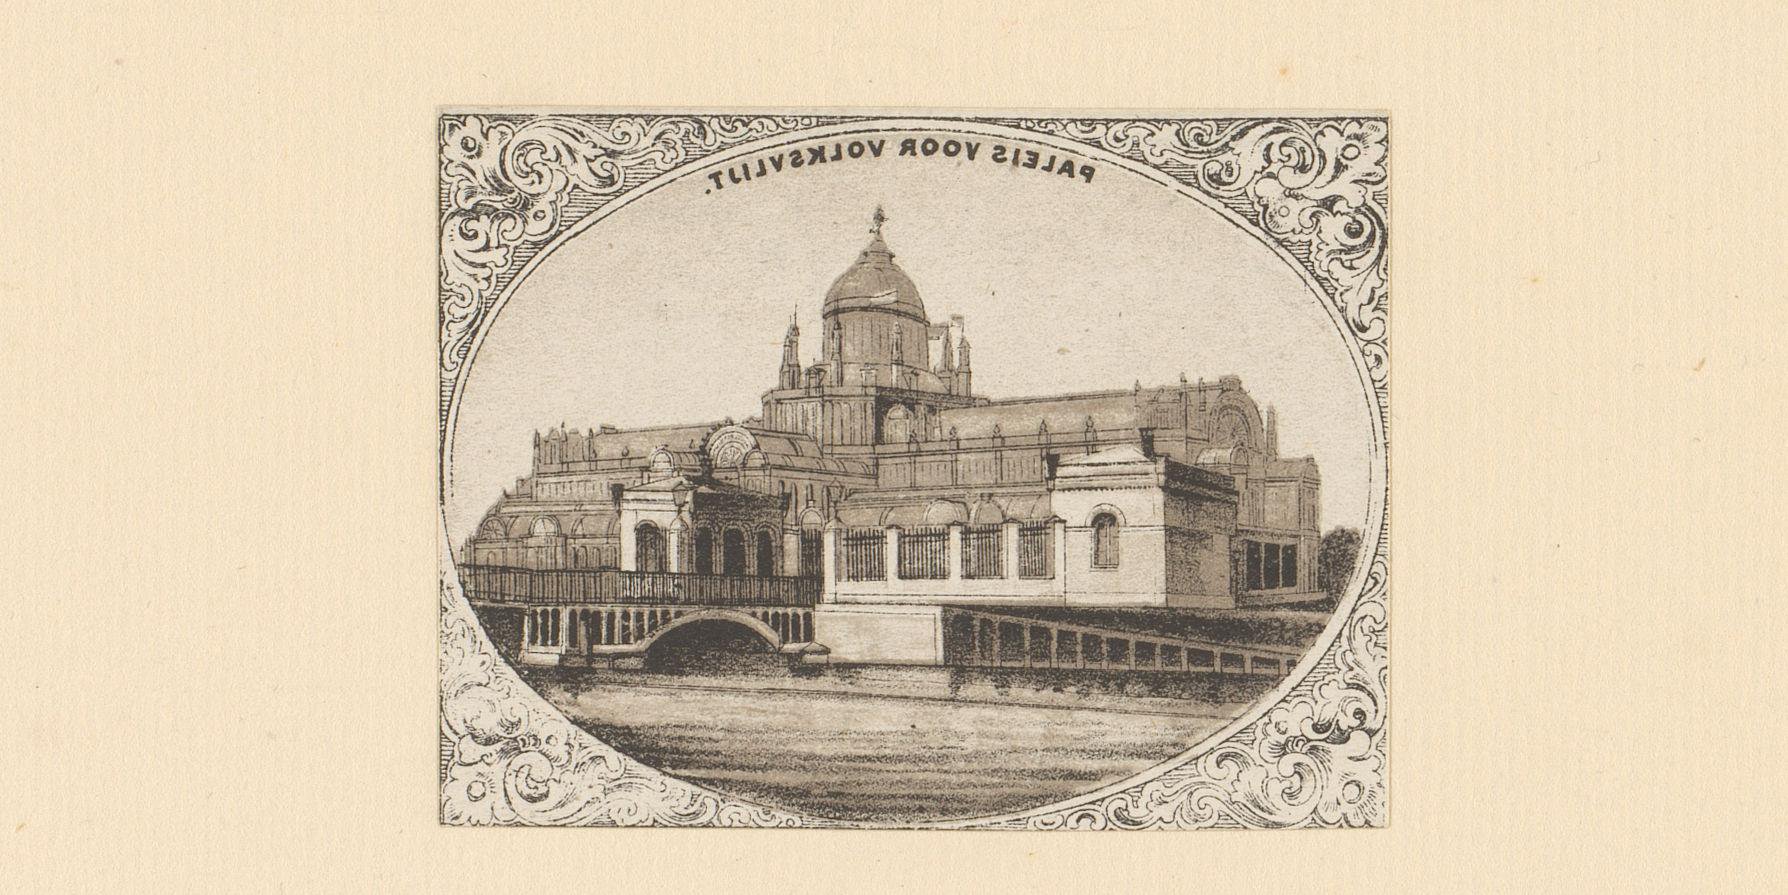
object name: print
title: Paleis voor Volksvlijt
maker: Anonymous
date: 1864-1875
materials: paper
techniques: lithograph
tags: exterior ~ representation of a building